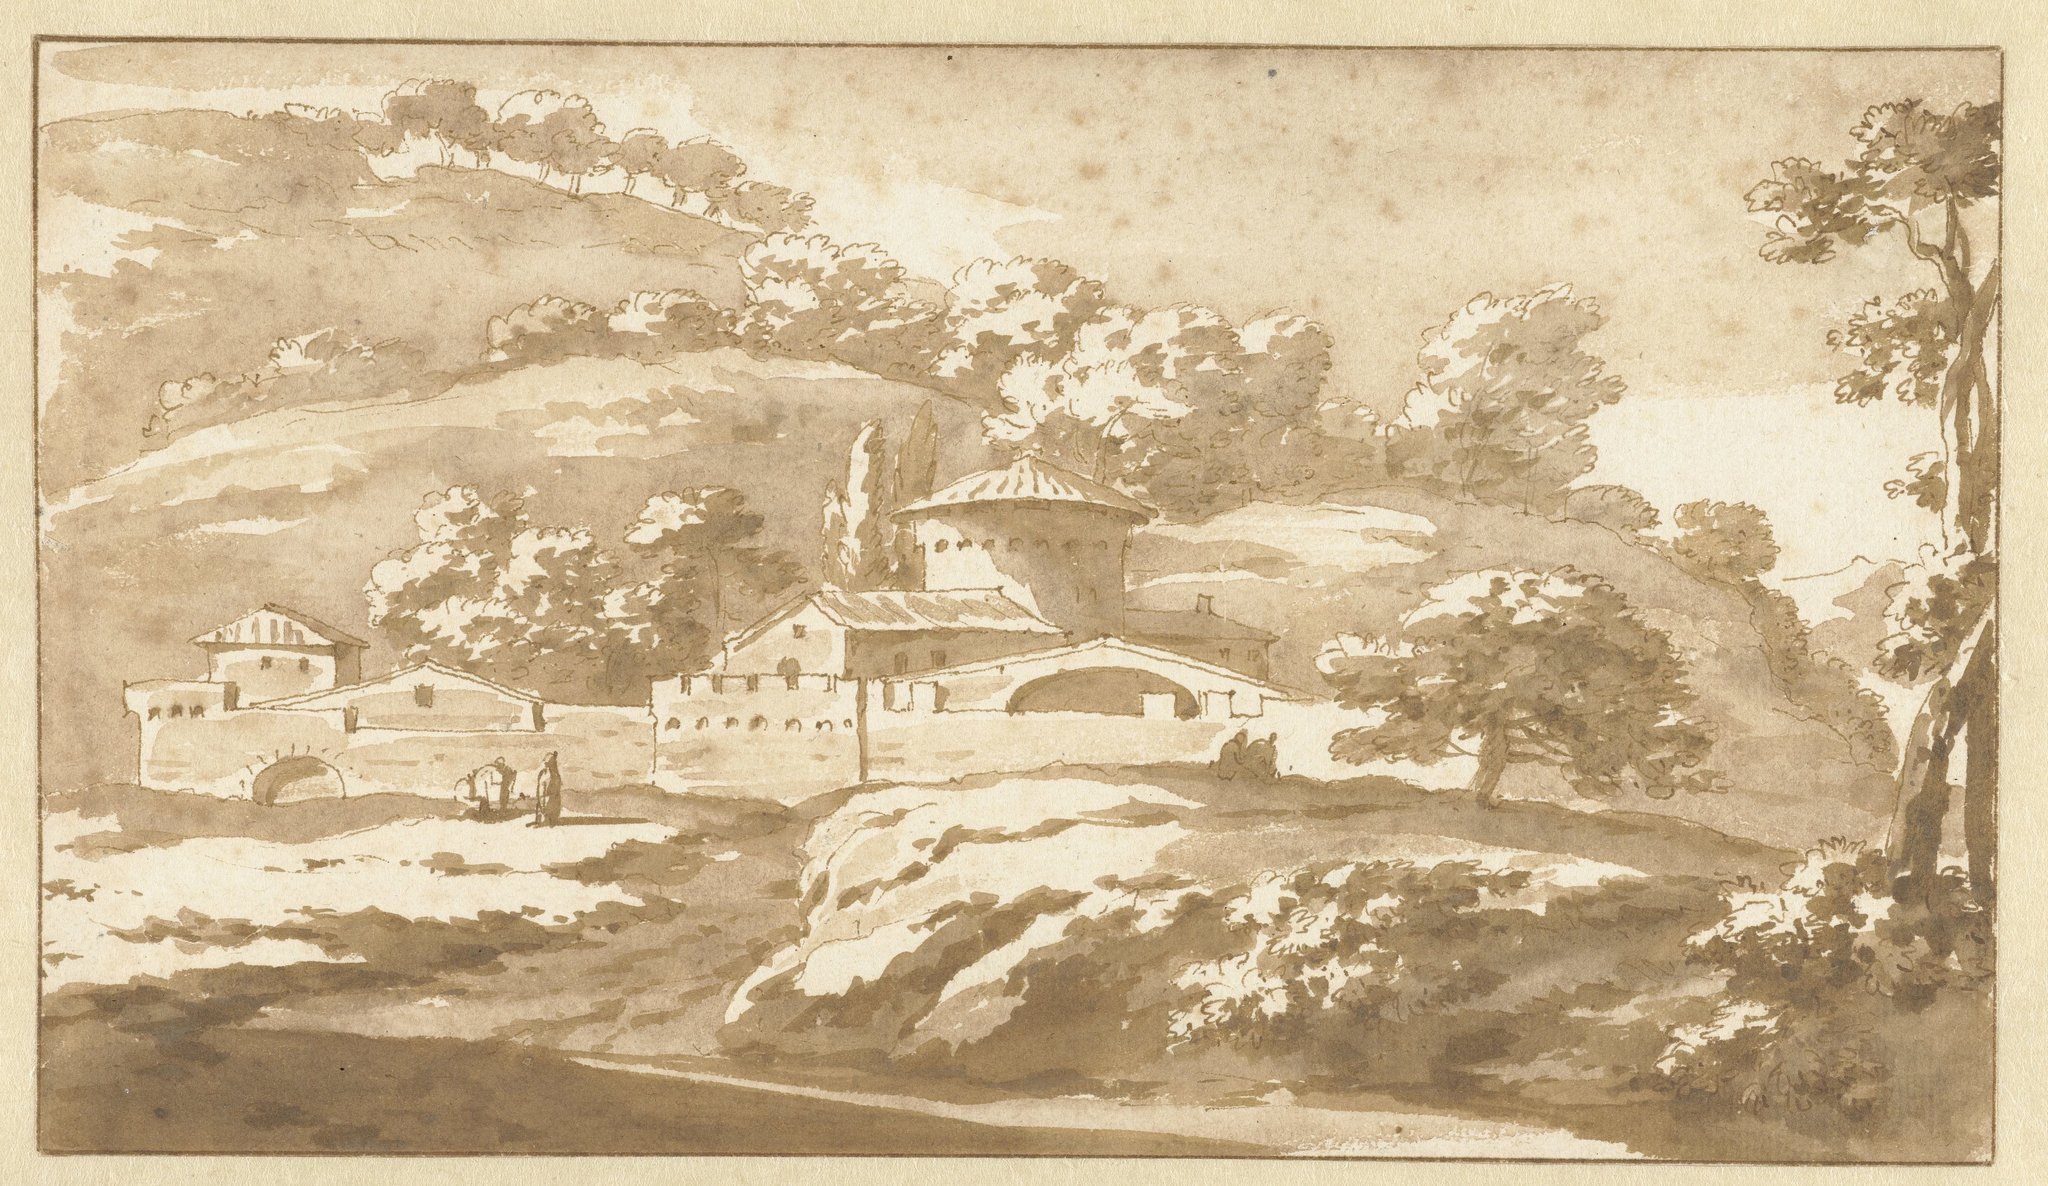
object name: drawing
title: Italiaans landschap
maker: jacob van der ulft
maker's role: draughtsman, painter, print maker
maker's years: 1627-1689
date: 1637-1689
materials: ink, paper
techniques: brush, pen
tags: farm or solitary house in landscape